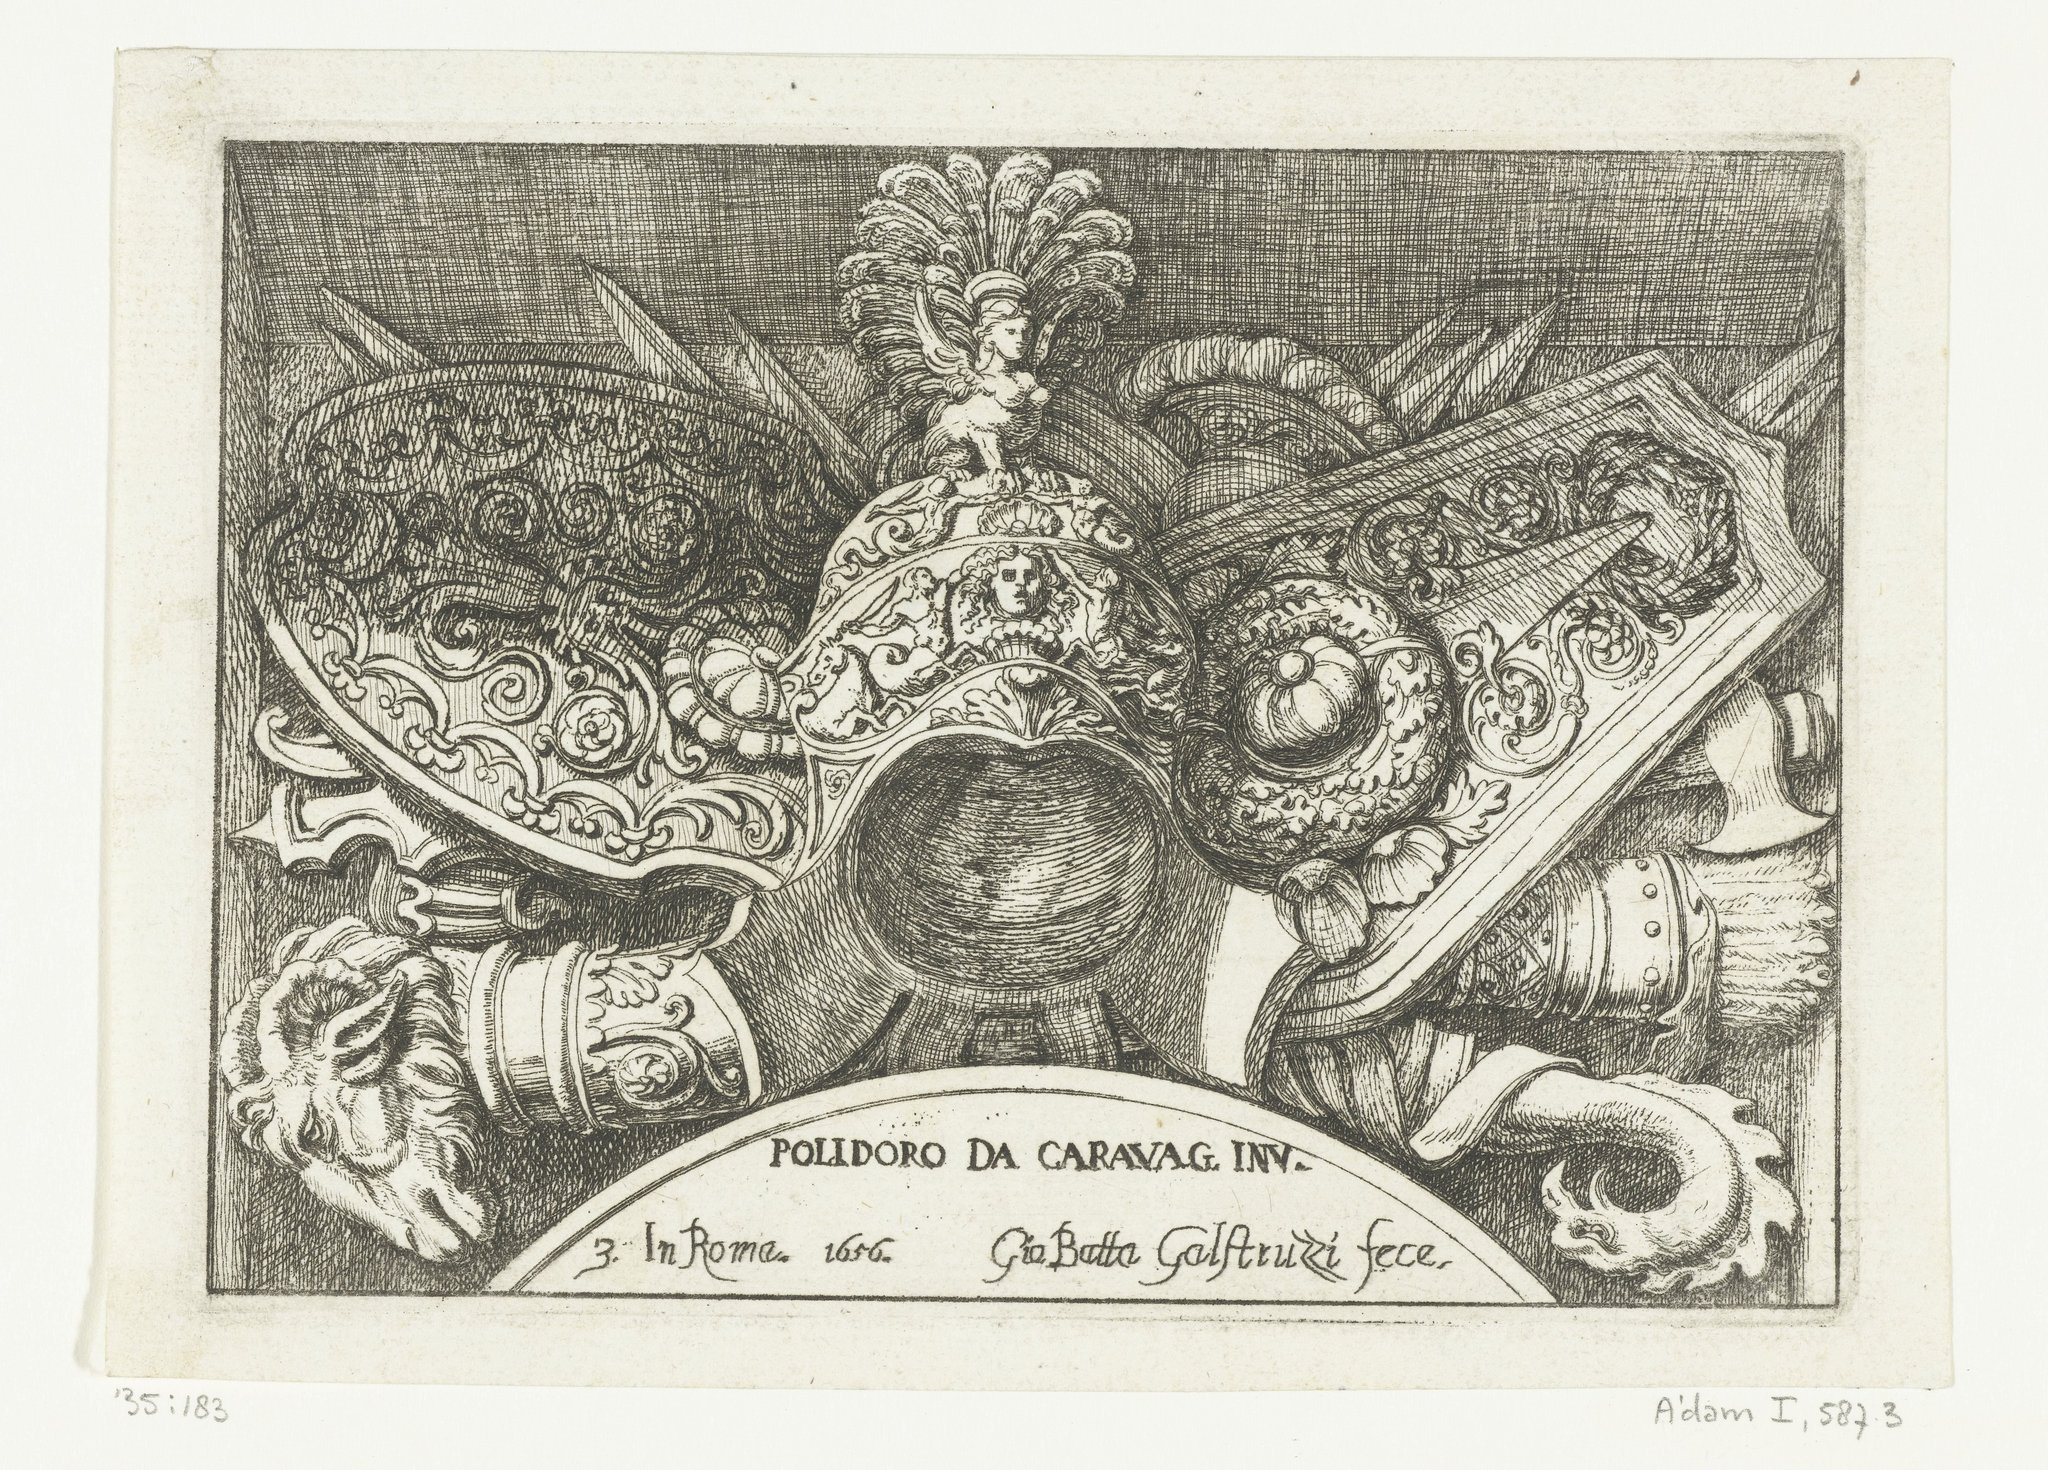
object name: ornament print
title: Helm, bekroond door een sfinx met een hoofdtooi van veren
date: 1658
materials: paper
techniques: etching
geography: italy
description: Wapentrofee, liggend in een vierkante nis. Midden onder bevindt zich een halfrond wit vlak met inscriptie.